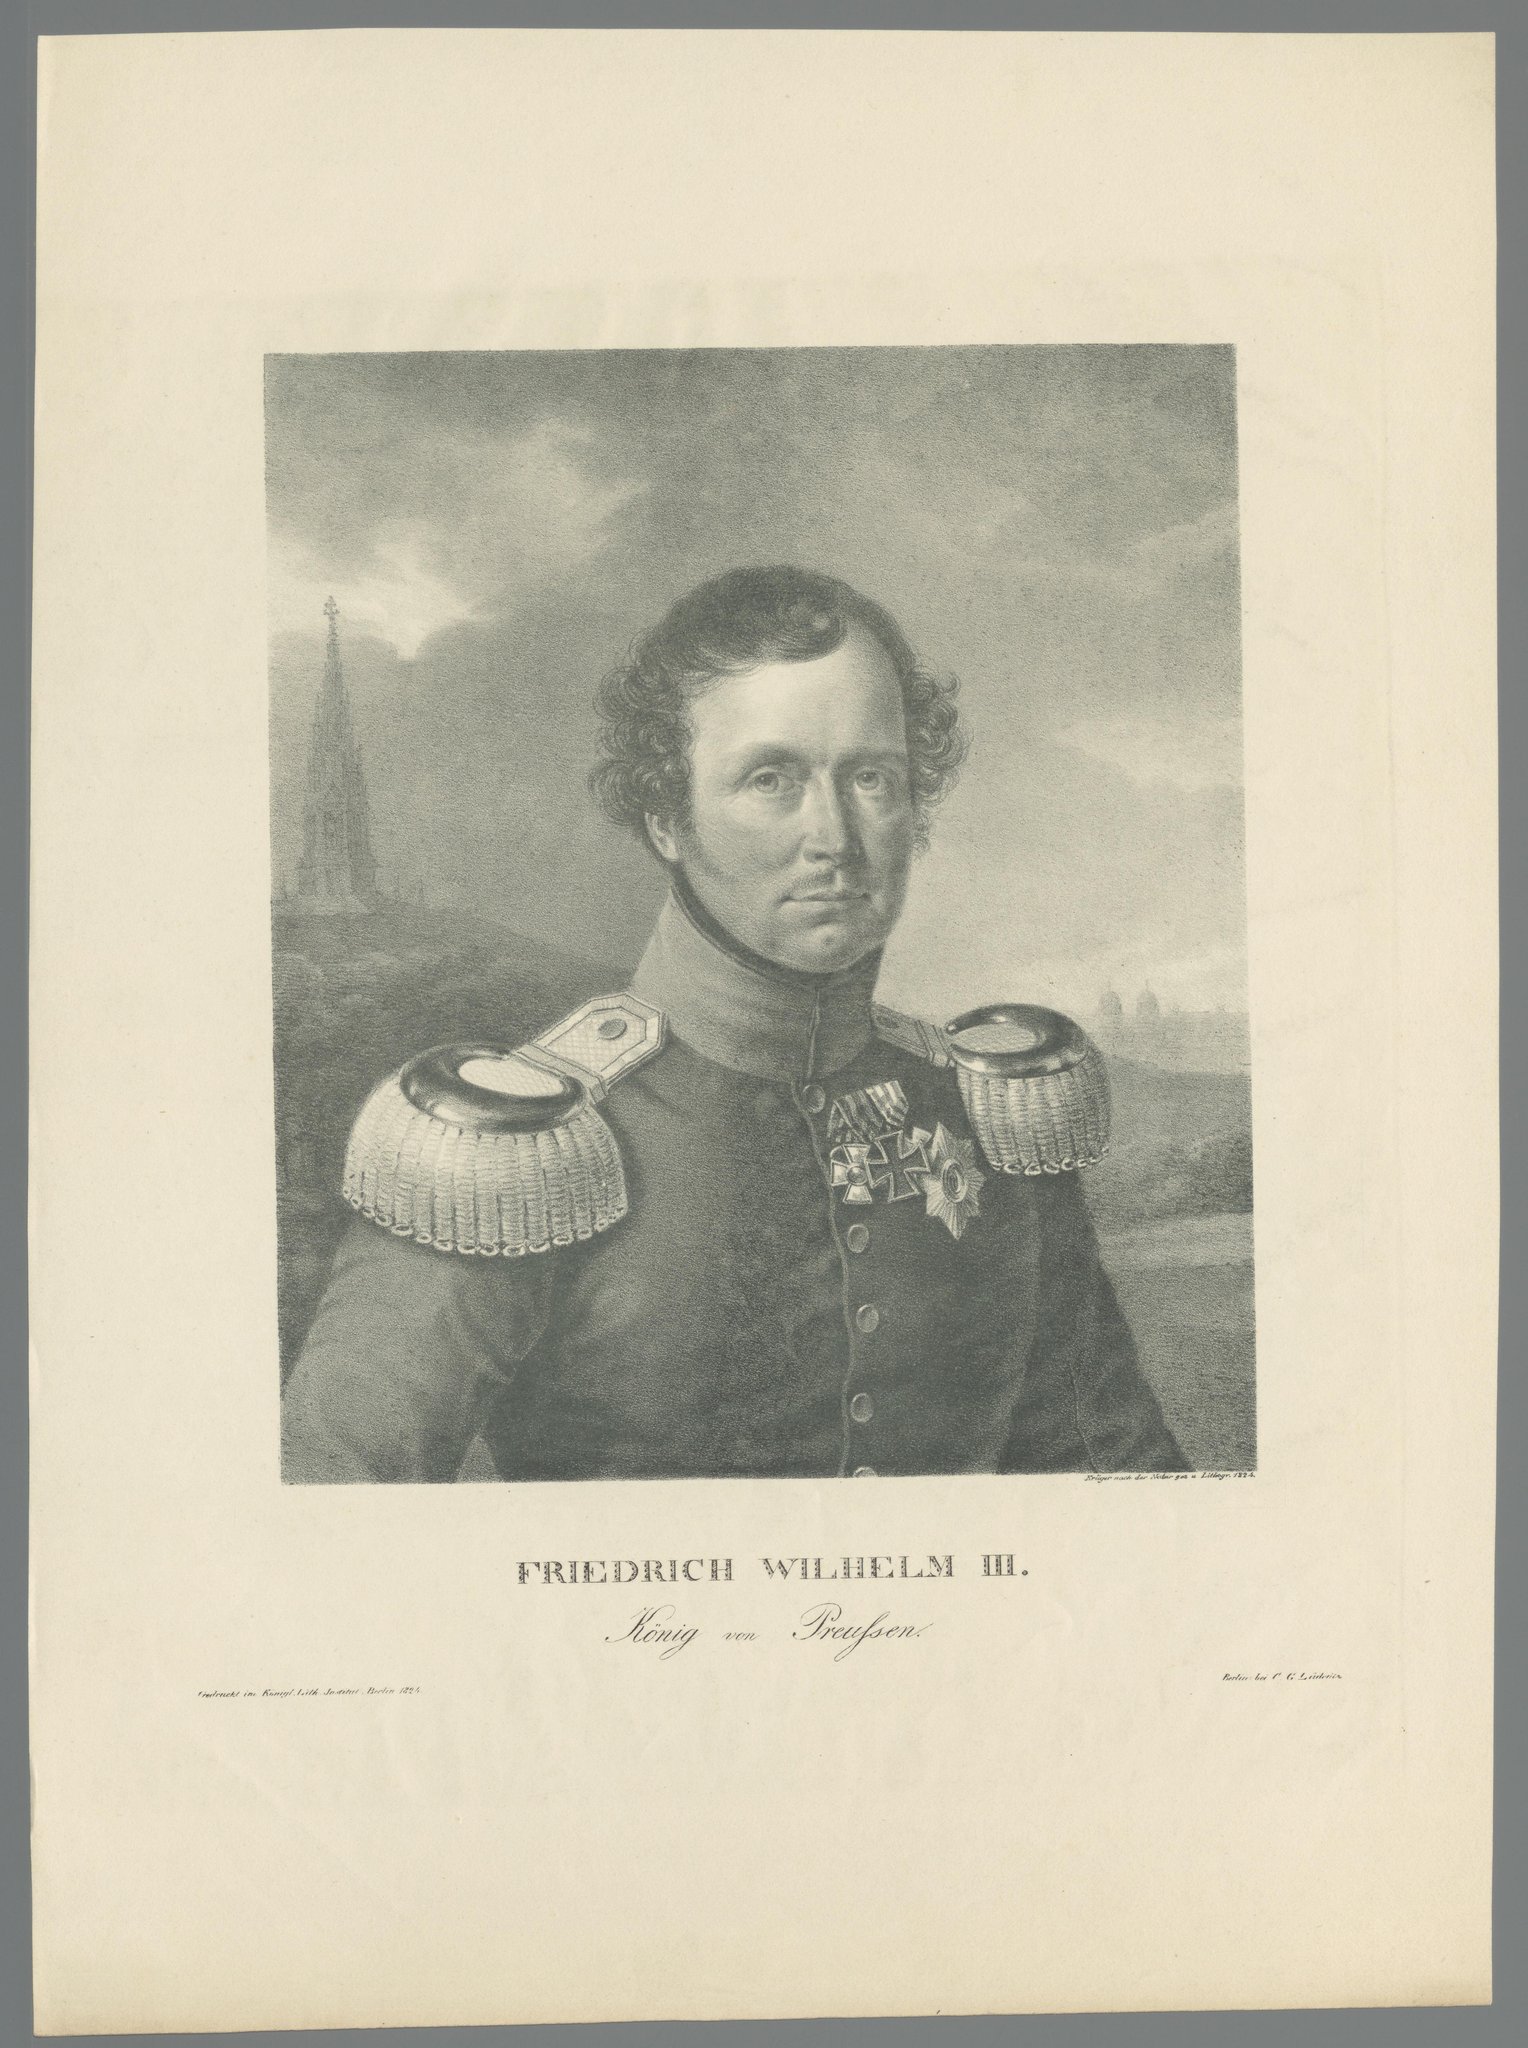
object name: print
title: Portret van Frederik Willem III koning van Pruisen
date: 1824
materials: paper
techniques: lithograph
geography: berlin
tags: berlin, frederik willem iii koning van pruisen, historical persons, king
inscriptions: collector's mark: Lugt 2228